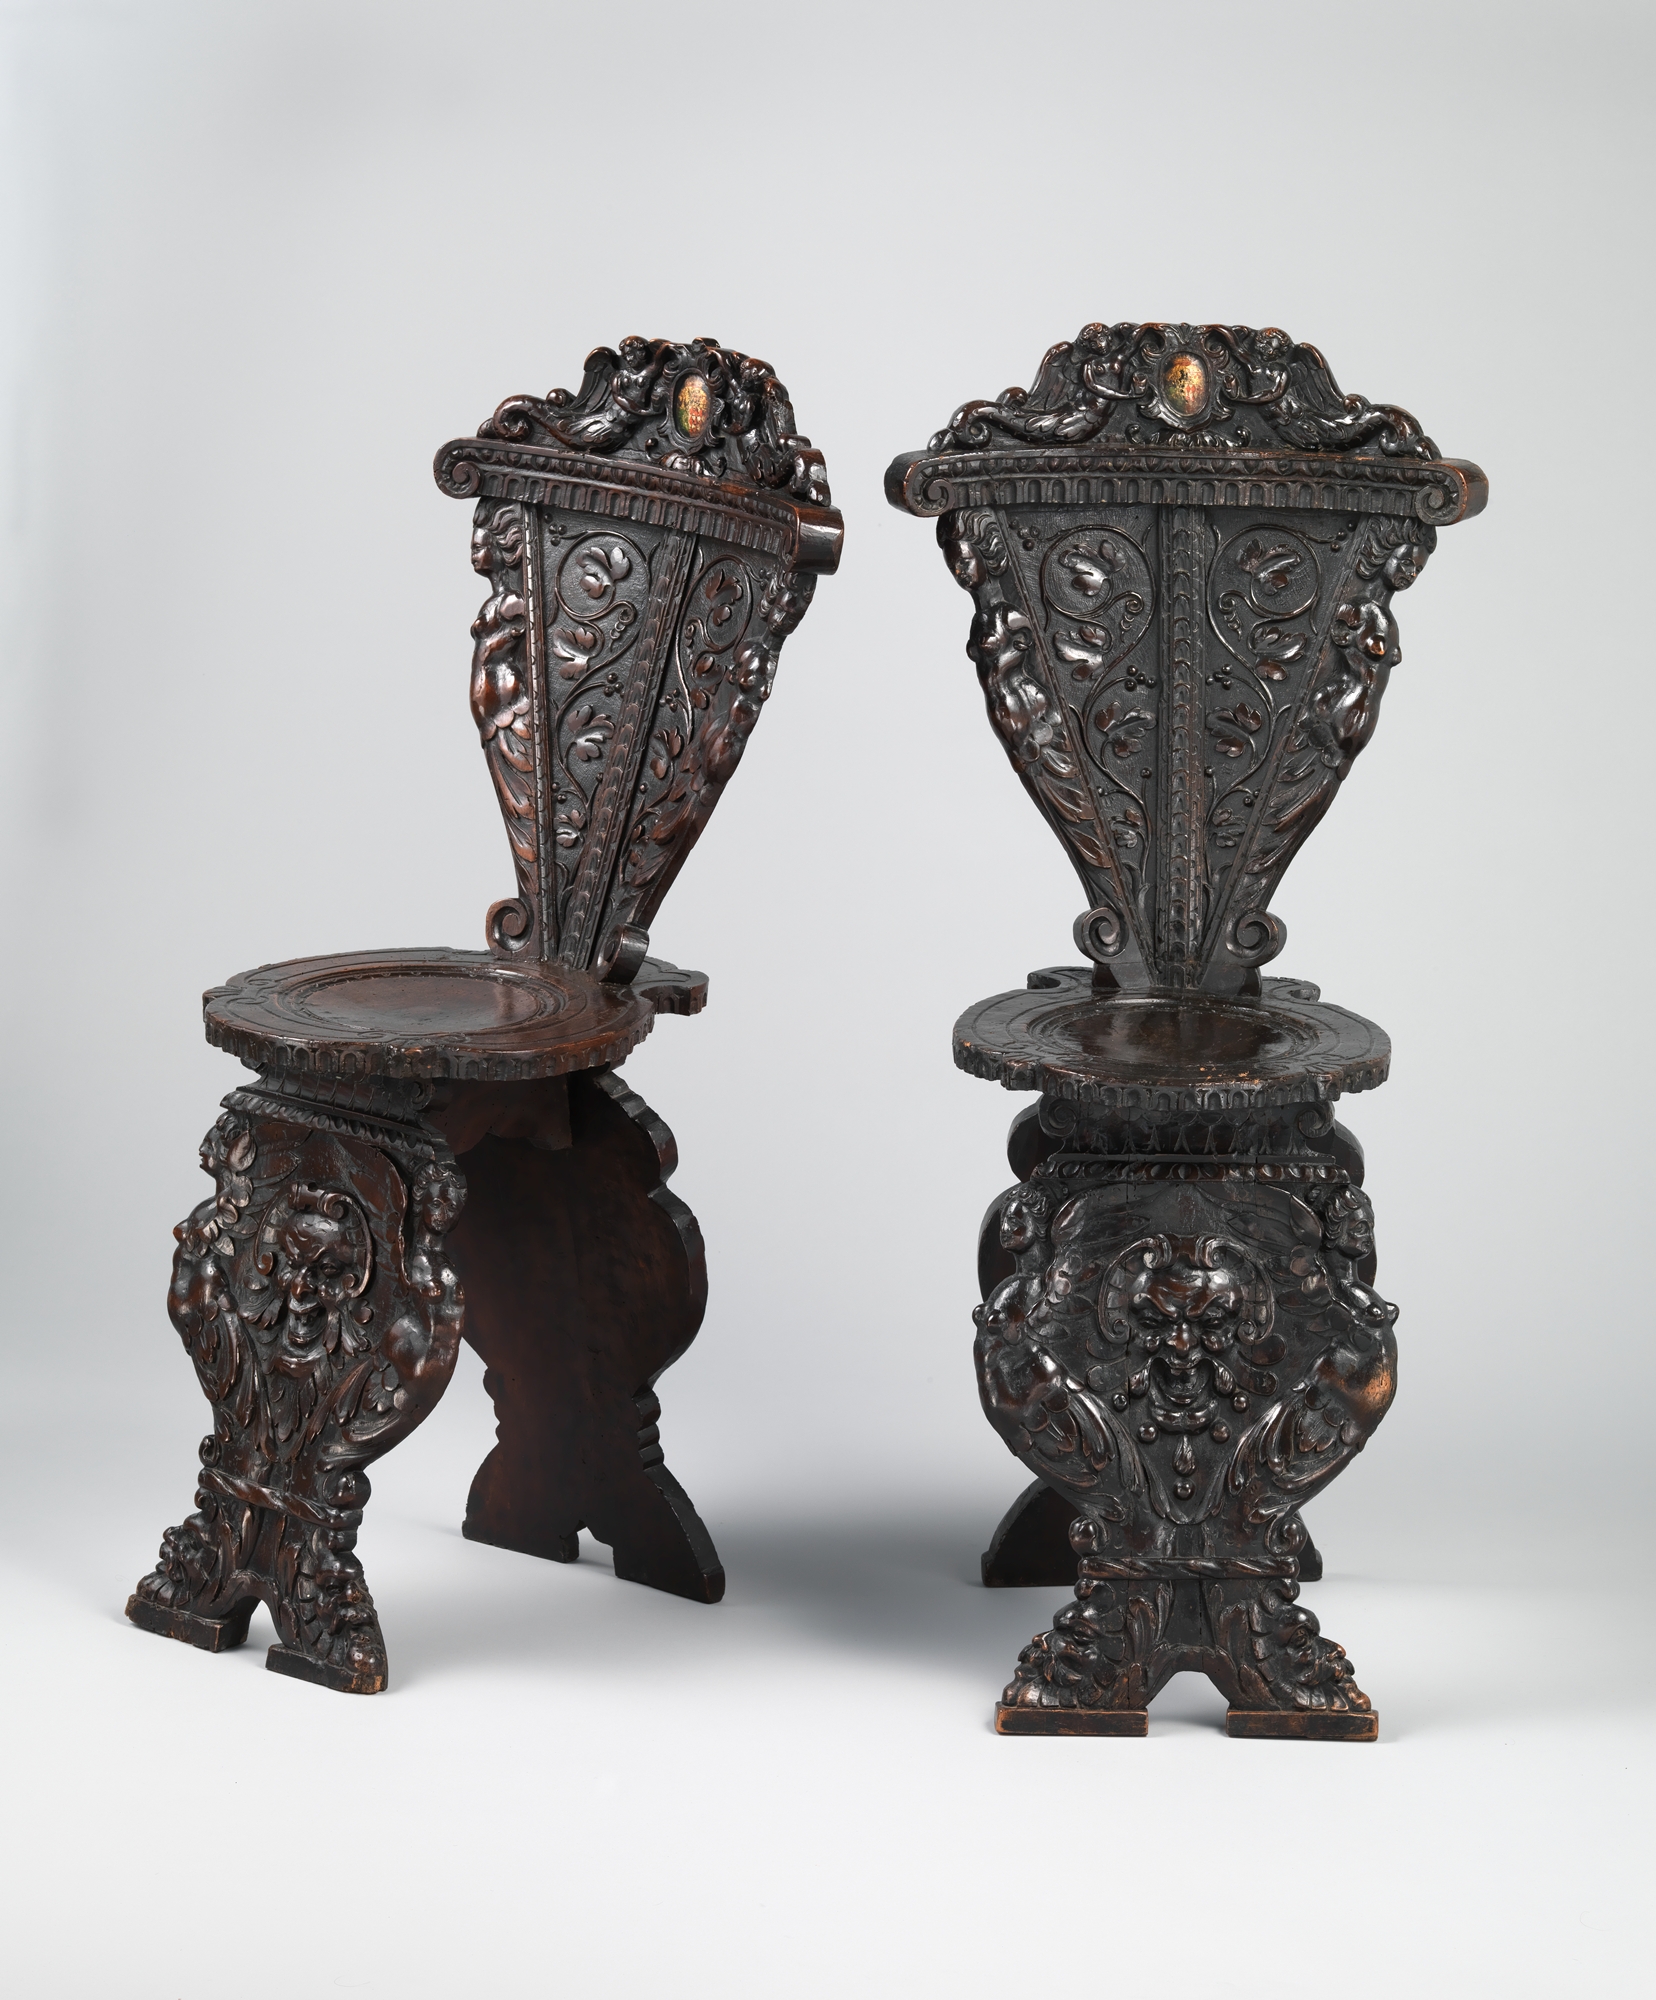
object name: sgabello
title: Sgabello (one of a pair)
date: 1575-1600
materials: wood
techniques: carving, painting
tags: masks,coat of arms